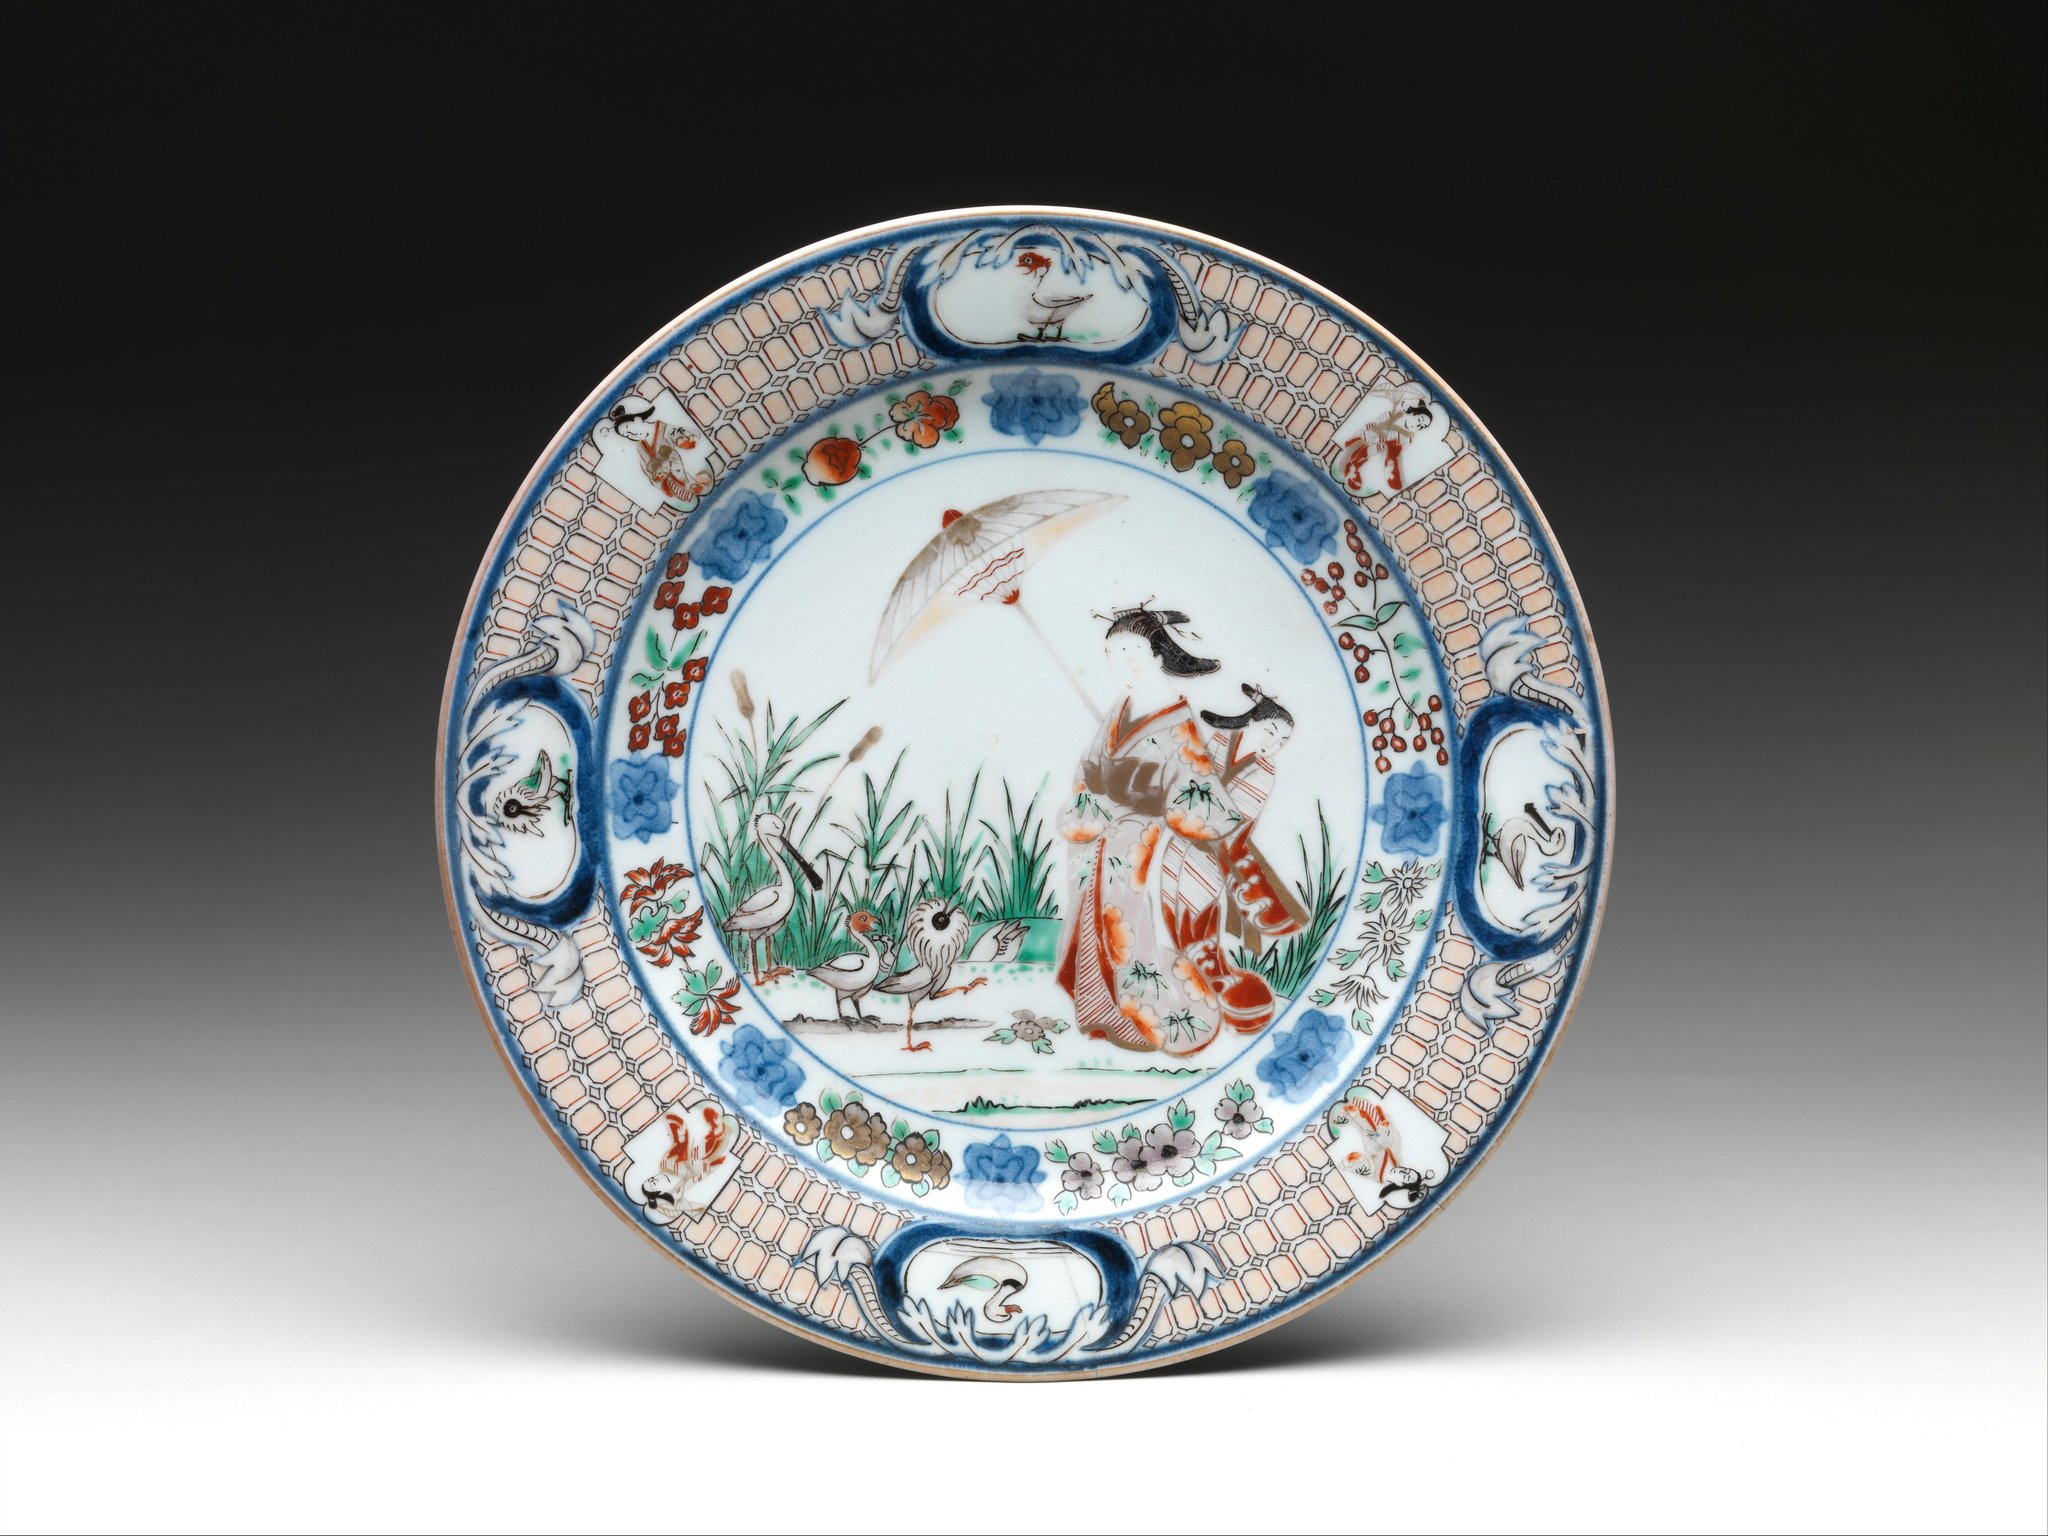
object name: plate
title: Plate Depicting Lady with a Parasol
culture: japanese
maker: cornelis pronk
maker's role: artist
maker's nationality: dutch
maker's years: 1691-1759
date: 1734-1737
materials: cobalt, enamel, glaze, porcelain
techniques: painting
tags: birds,women,parasols